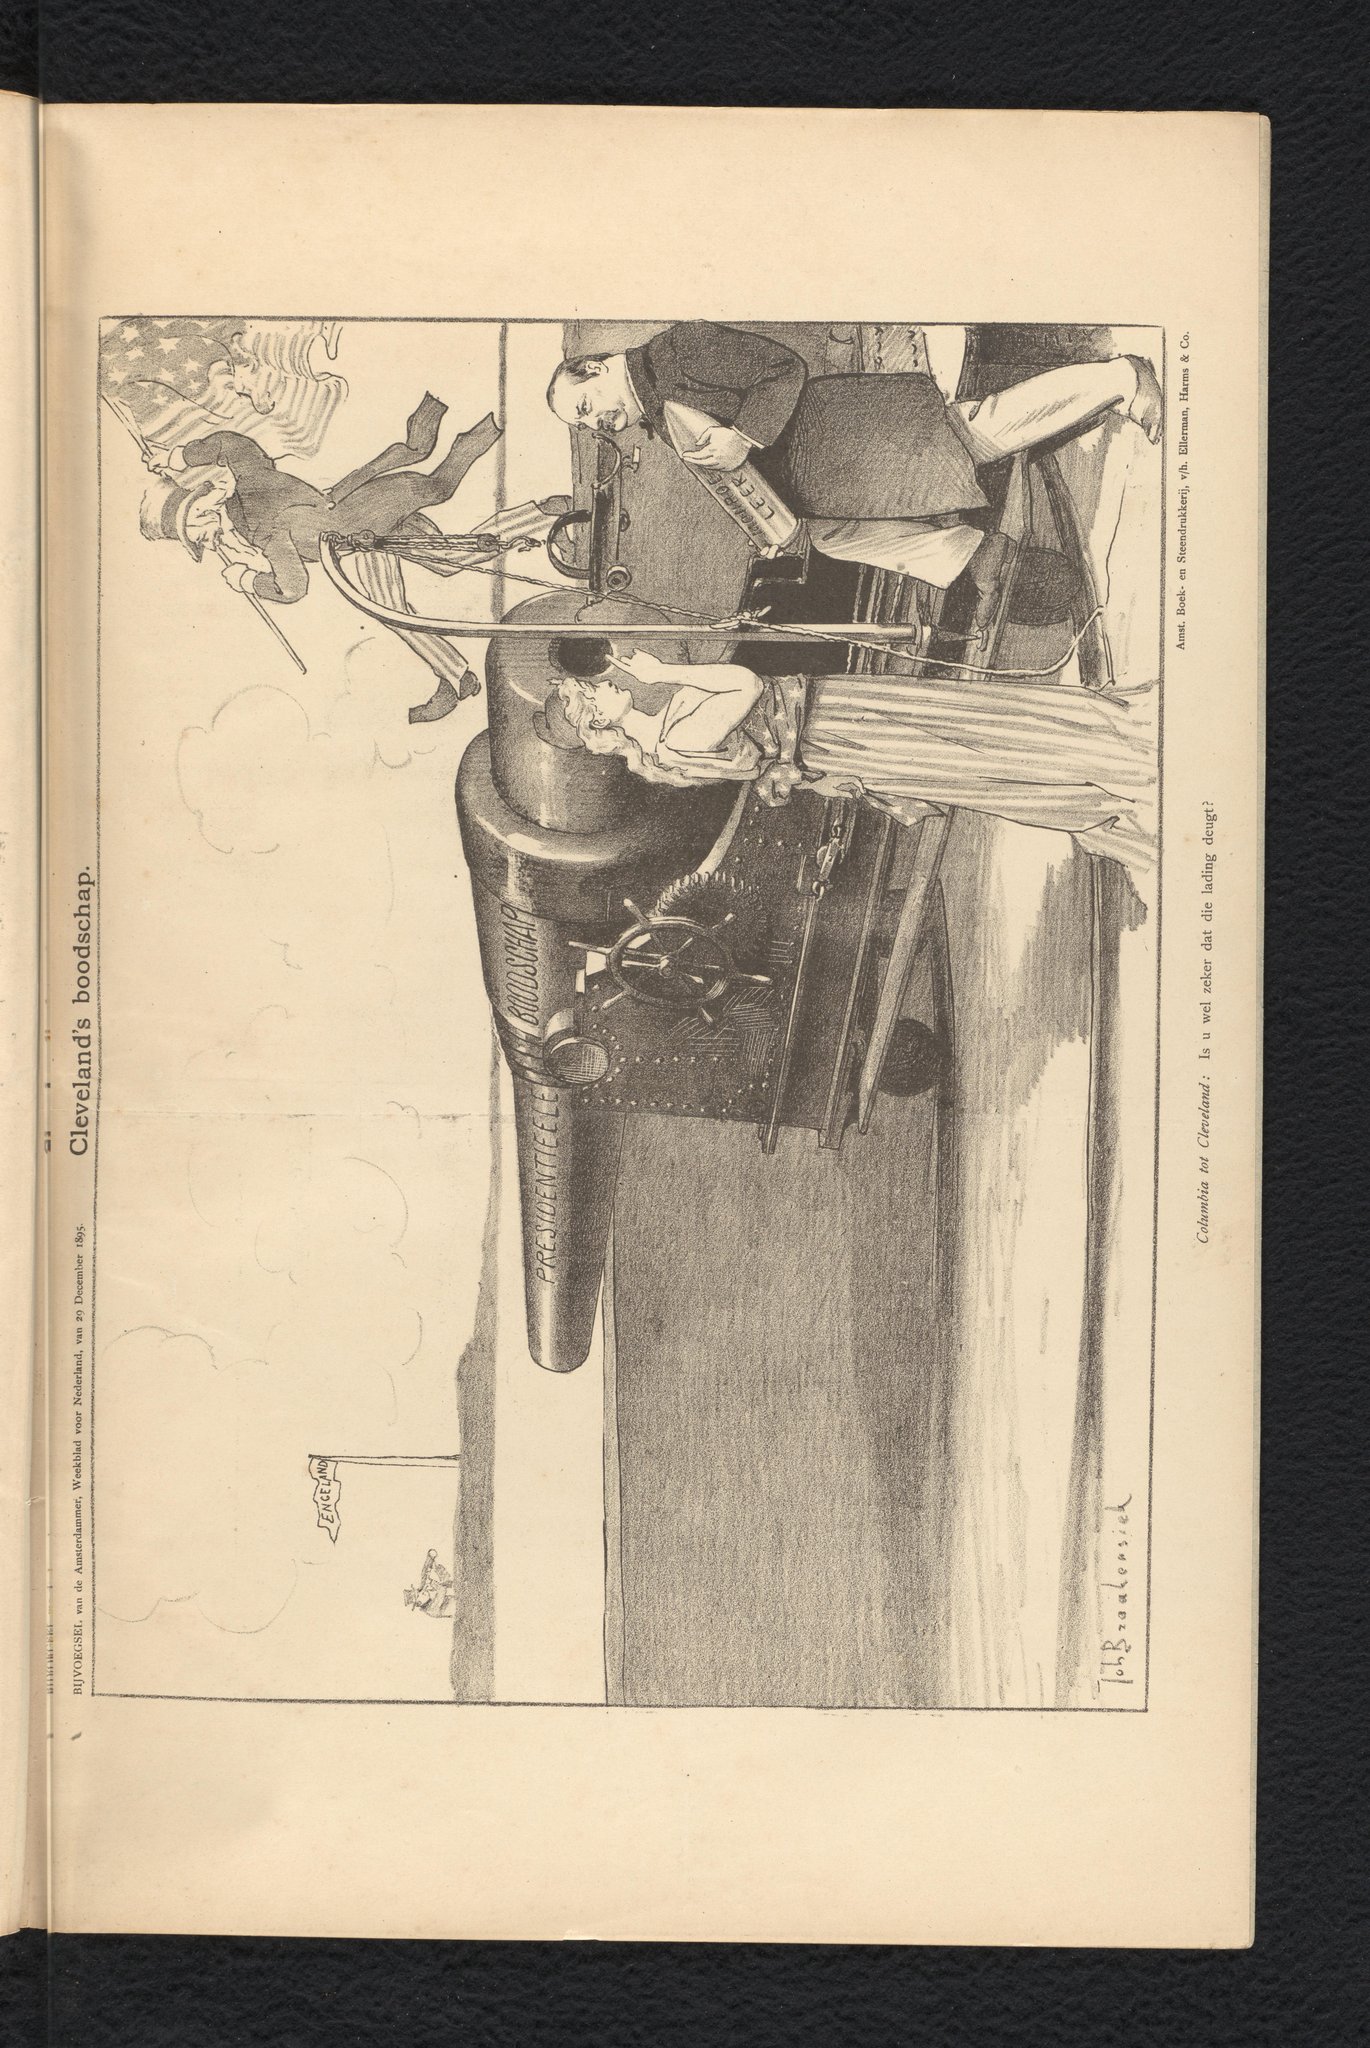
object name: cartoon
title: Cleveland's boodschap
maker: johan braakensiek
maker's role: draughtsman, print maker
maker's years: 1858-1940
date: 1895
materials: paper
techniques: lithograph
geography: amsterdam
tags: personifications of countries, nations, states, districts, etc., projectiles, explosives, etc. (with name), firearms: cannon, political caricatures and satires, united states of america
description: Columbia (Verenigde Staten) vraagt aan de Amerikaanse president Grover Cleveland of de granaat 'Monroe-leer' wel de juiste is voor de enorme kanon die hij op Engeland heeft gericht. Op de kanon danst Uncle Sam met de Amerikaanse vlag.